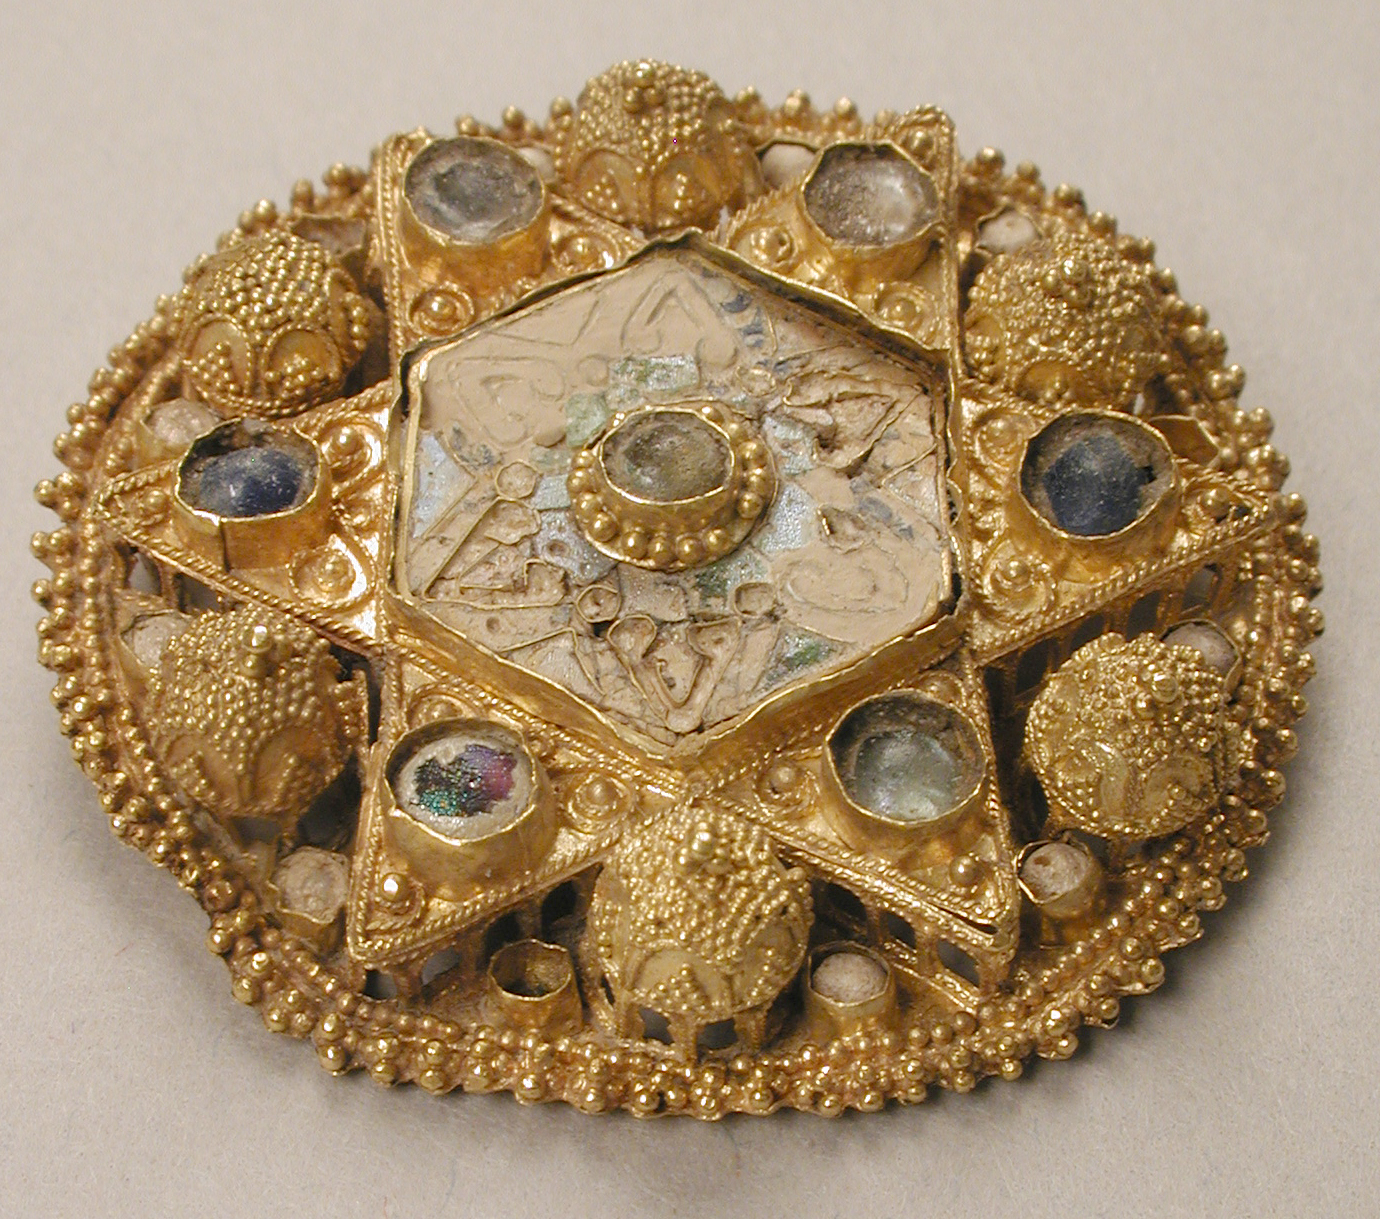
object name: brooch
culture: ottonian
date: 970-1030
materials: enamel, glass, gold, pearl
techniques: enamel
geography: italy